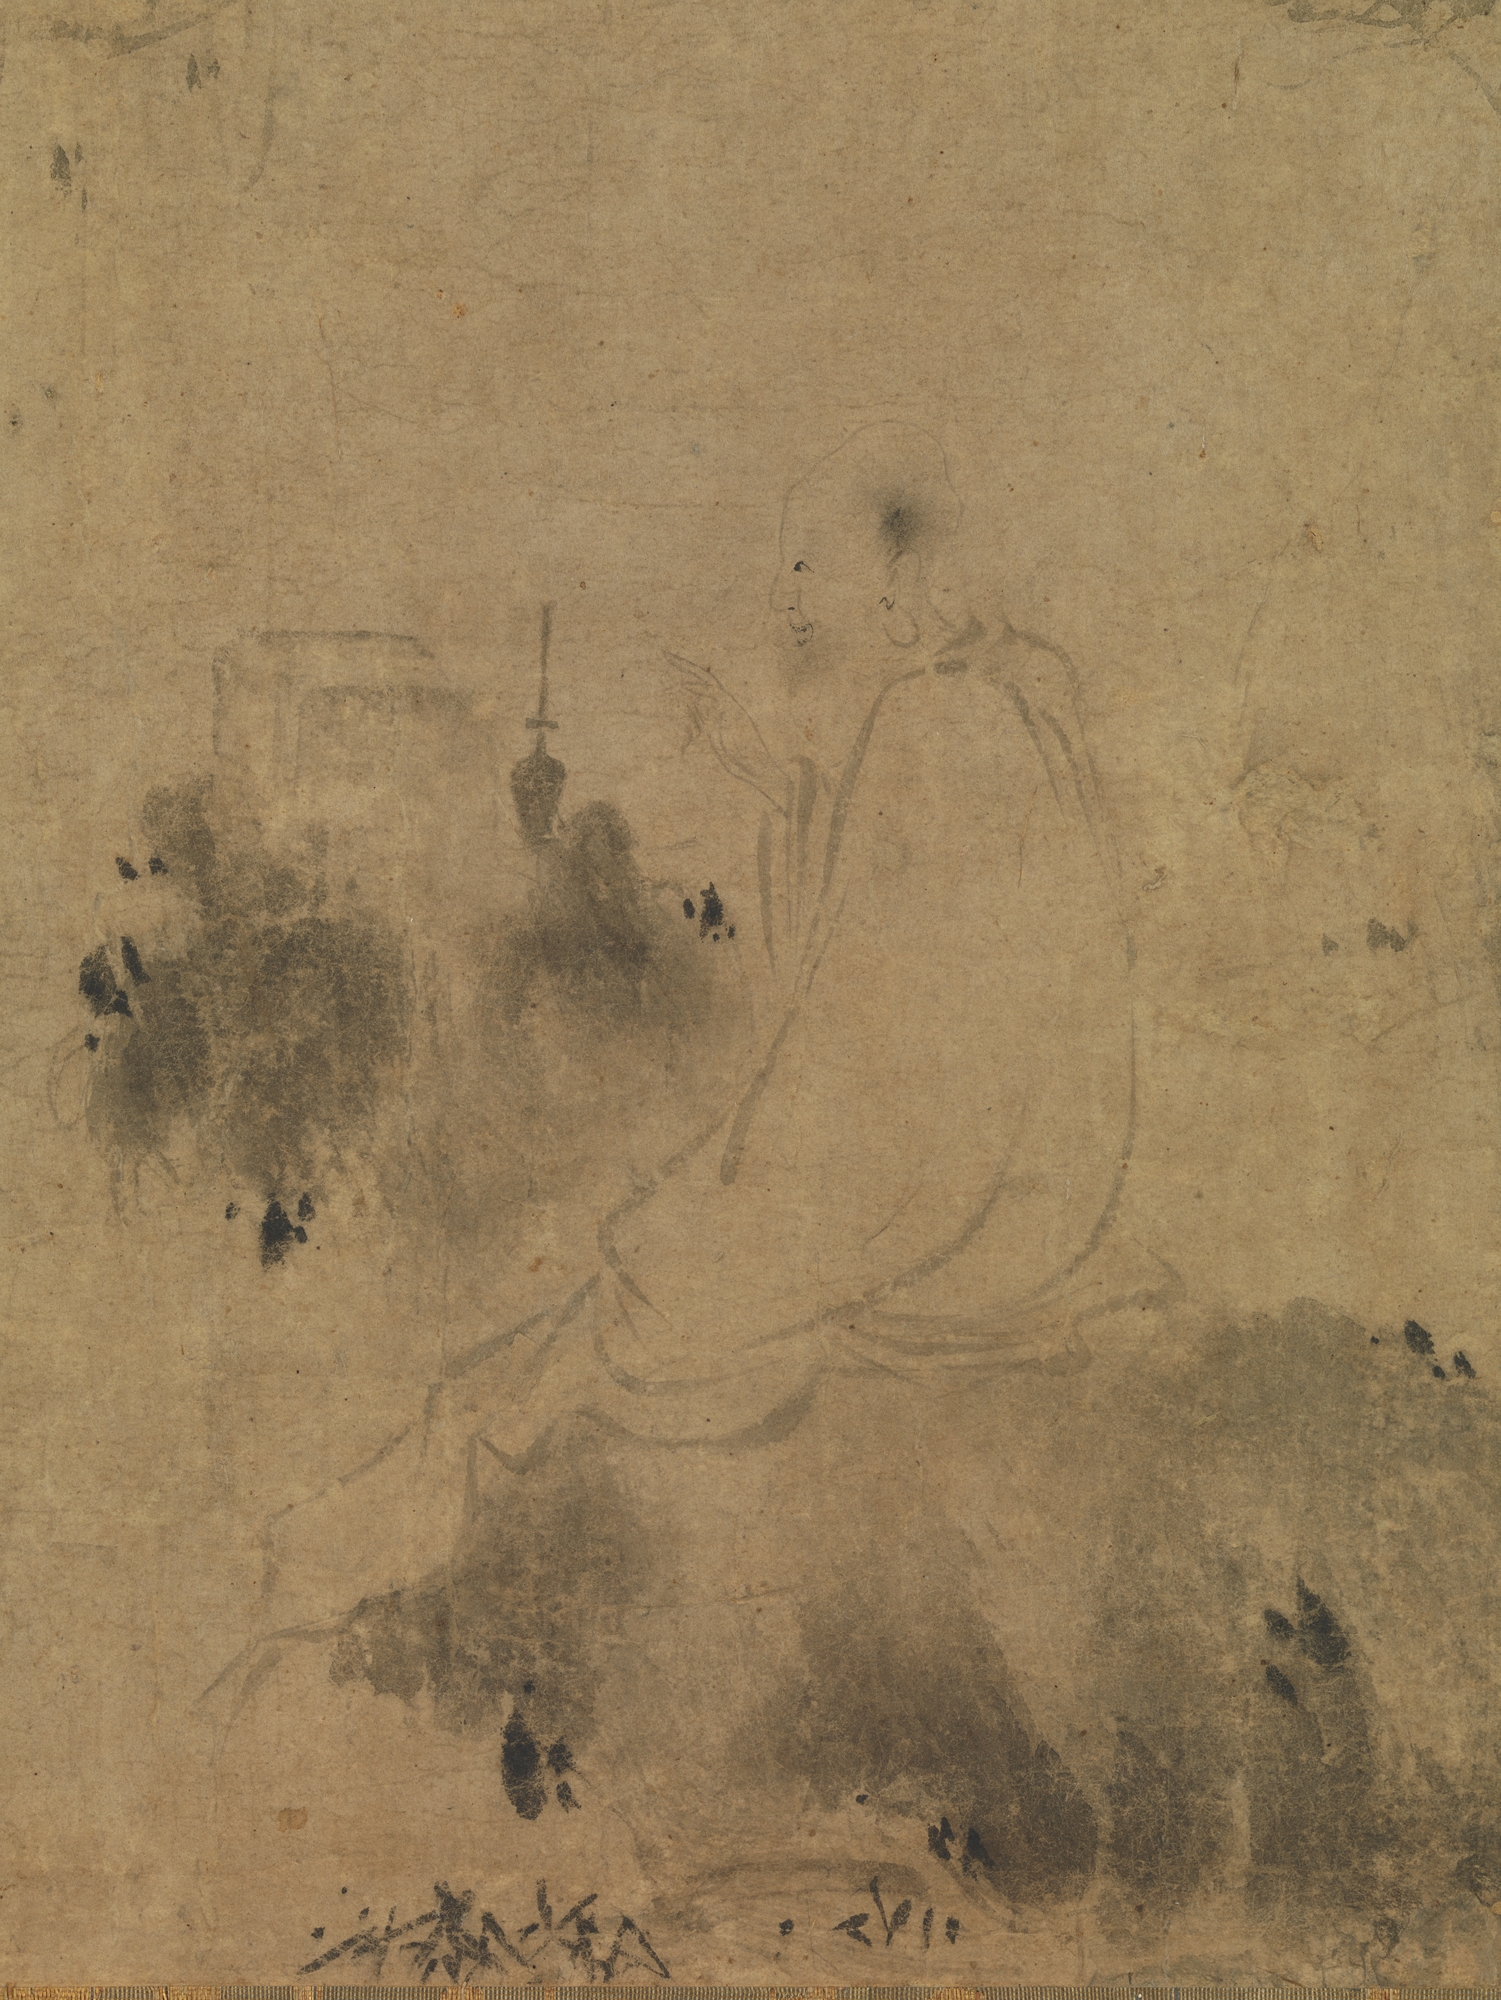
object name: hanging scroll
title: Meeting between Yaoshan and Li Ao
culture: chinese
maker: zhiweng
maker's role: artist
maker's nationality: chinese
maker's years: 1200-1250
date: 1256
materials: ink, paper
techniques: painting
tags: men